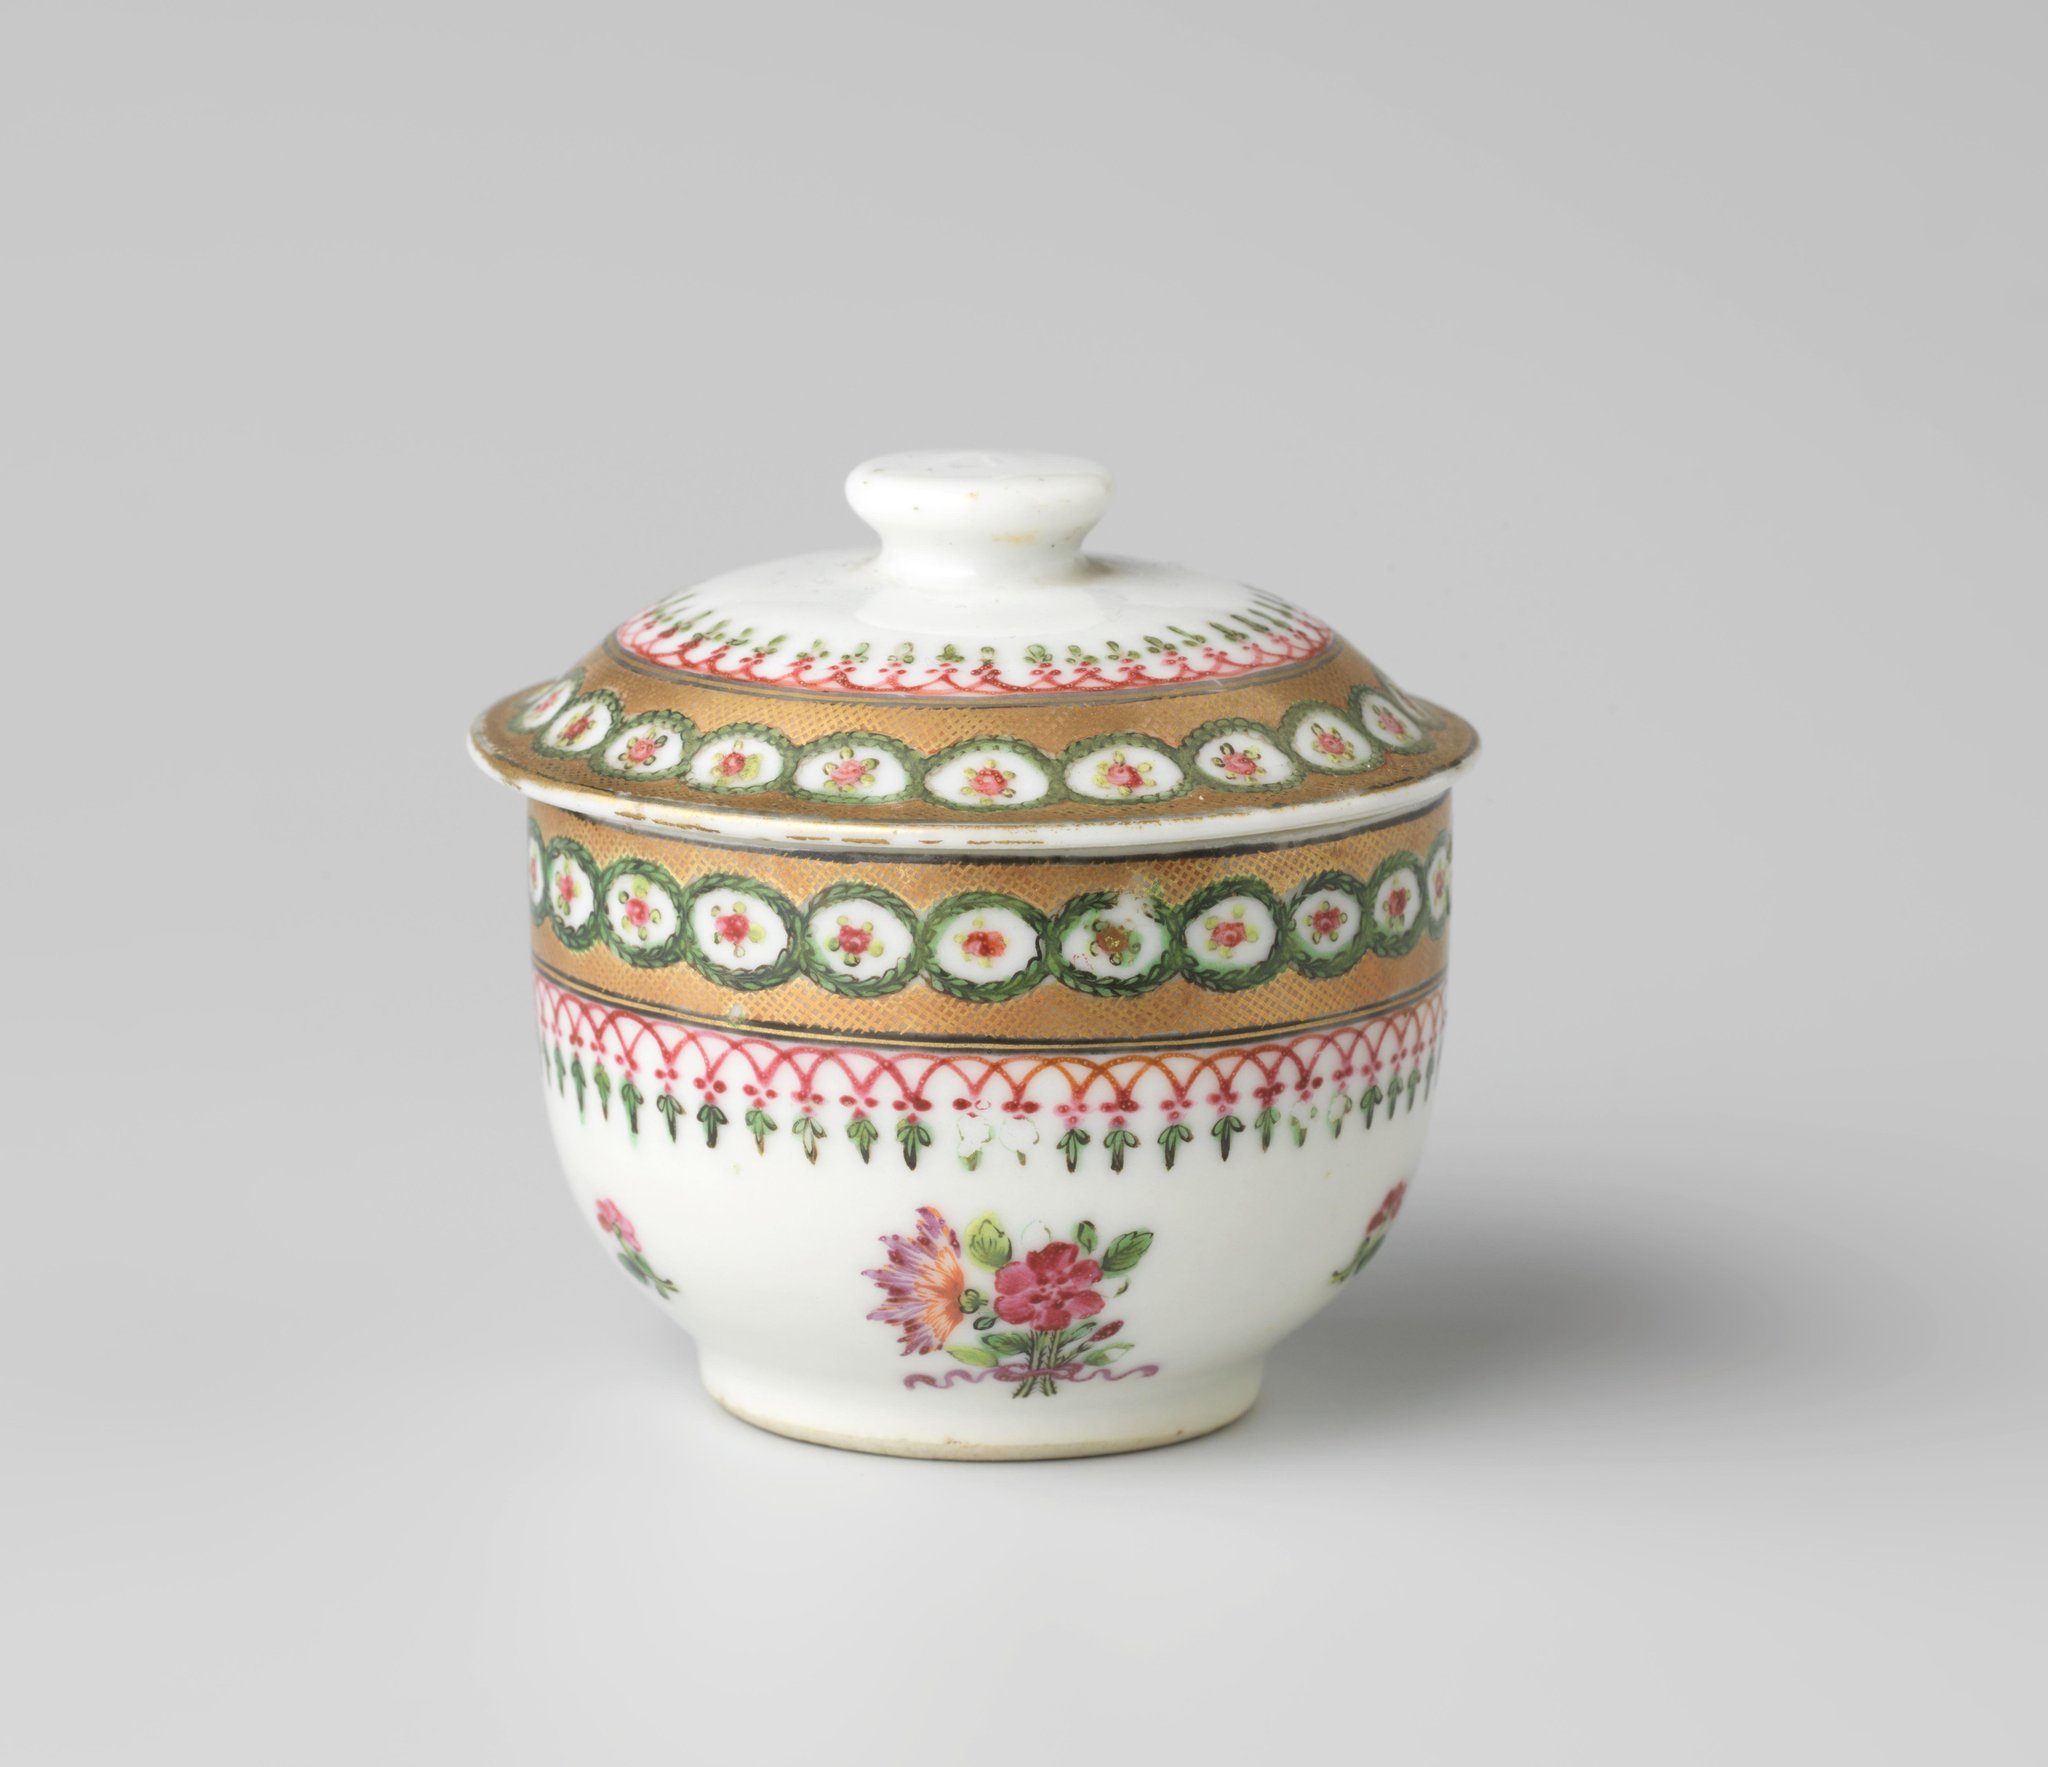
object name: covered bowl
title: Covered jar with bouquets, scattered flowers and ornamental borders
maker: Anonymous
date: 1775-1799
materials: glaze, gold, paint, porcelain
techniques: firing, gilding, turning, vitrification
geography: china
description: Dekselkom van porselein met een rechte wand, beschilderd op het glazuur in rood, roze, groen, paars, zwart en goud. De wand van de kom met twee boeketten met vier losse bloemen; om de buitenrand een brede decoratieve band met servetwerk, een band met bloemen en een 'spearhead-border'. De deksel met dezelfde decoratie en een platte knop. Famille rose.